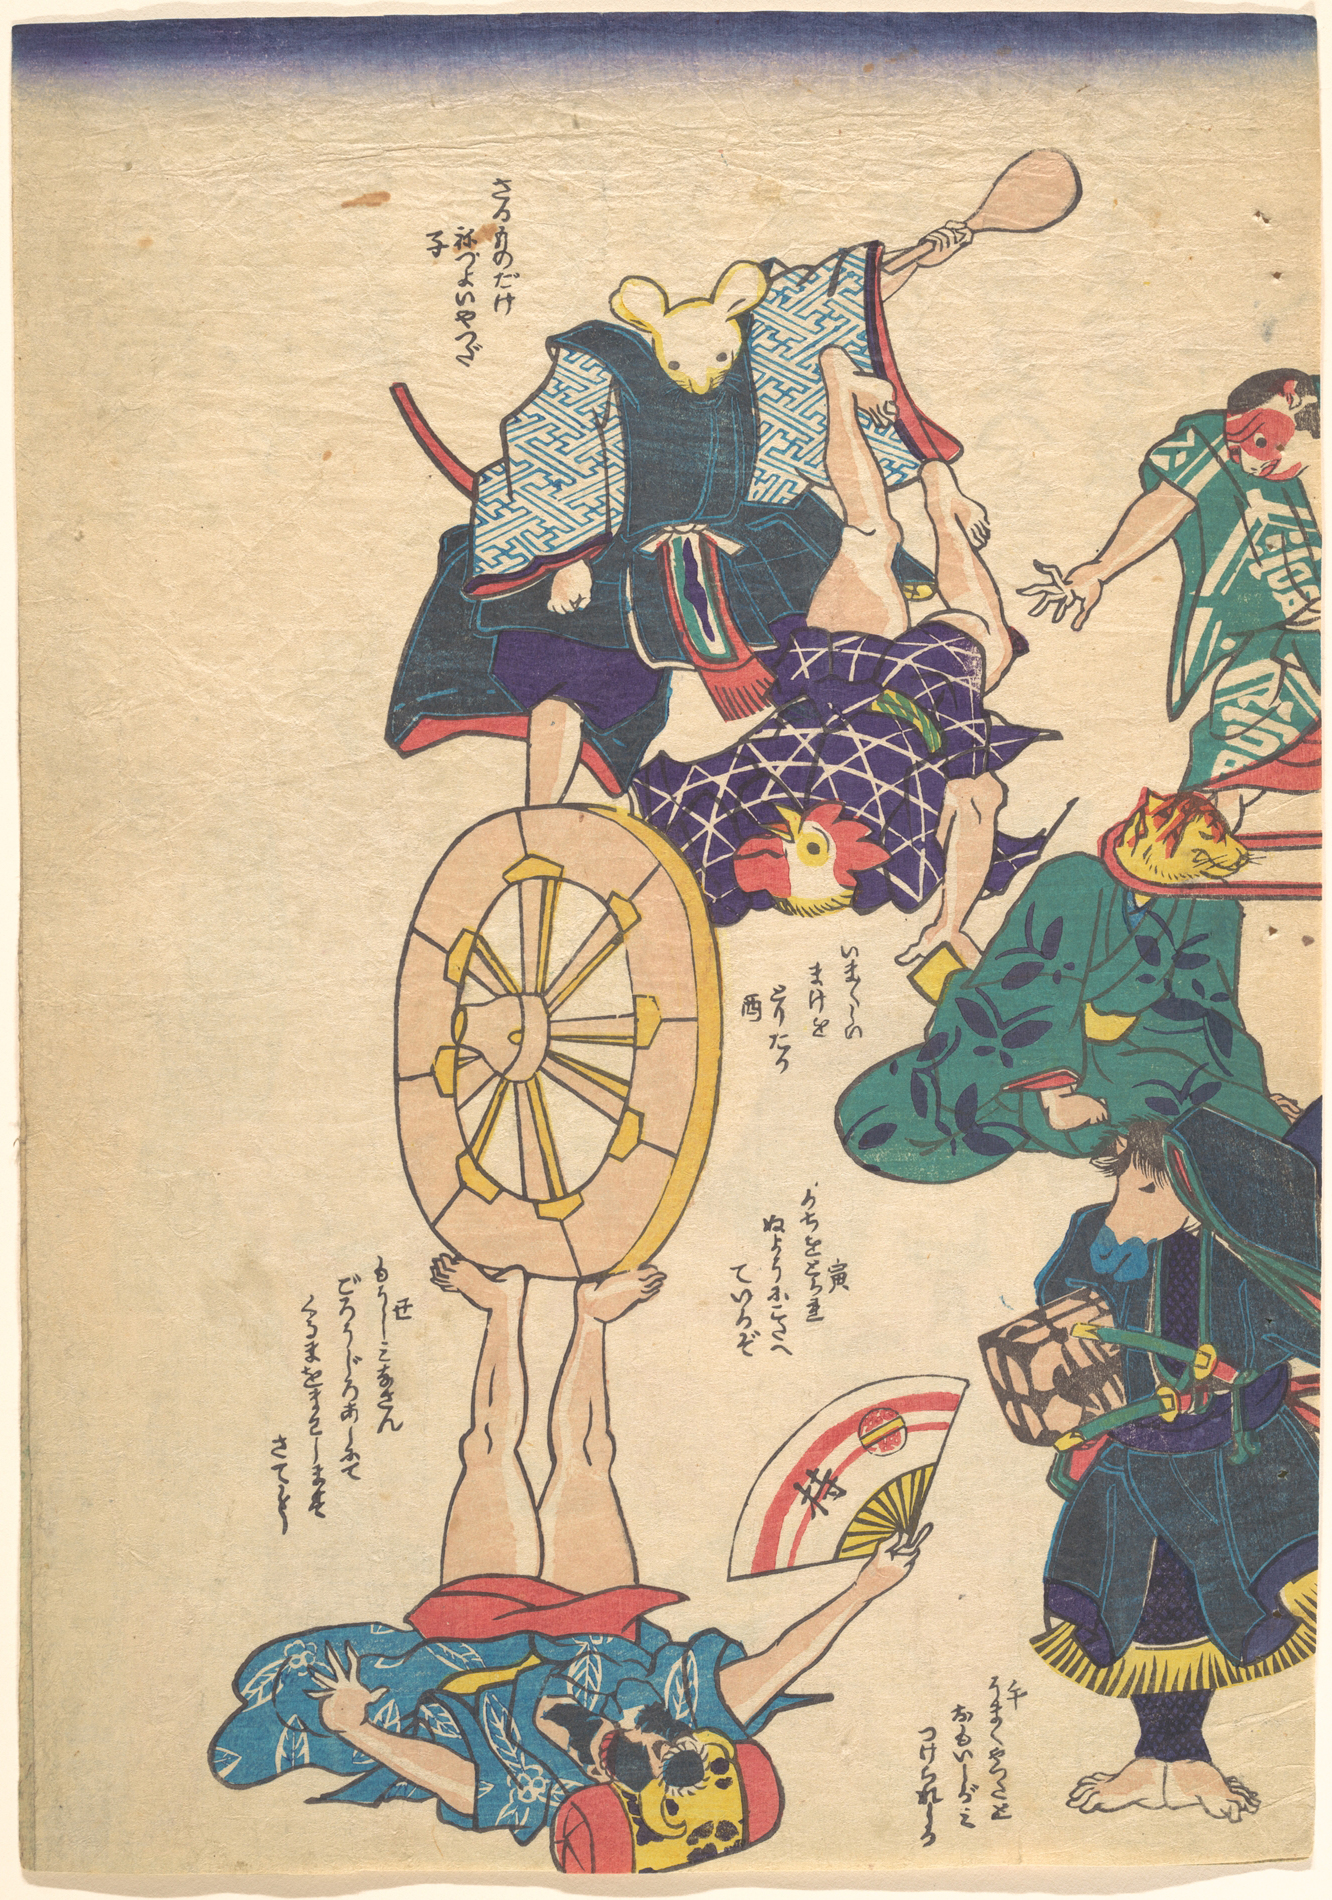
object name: print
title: Craftsman by the Twelve Sign of Zodiac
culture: japanese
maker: utagawa kuniyoshi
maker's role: artist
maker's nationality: japanese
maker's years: 1797-1861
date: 1801-1900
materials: ink, paper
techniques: woodblock print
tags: human figures,masks,zodiac